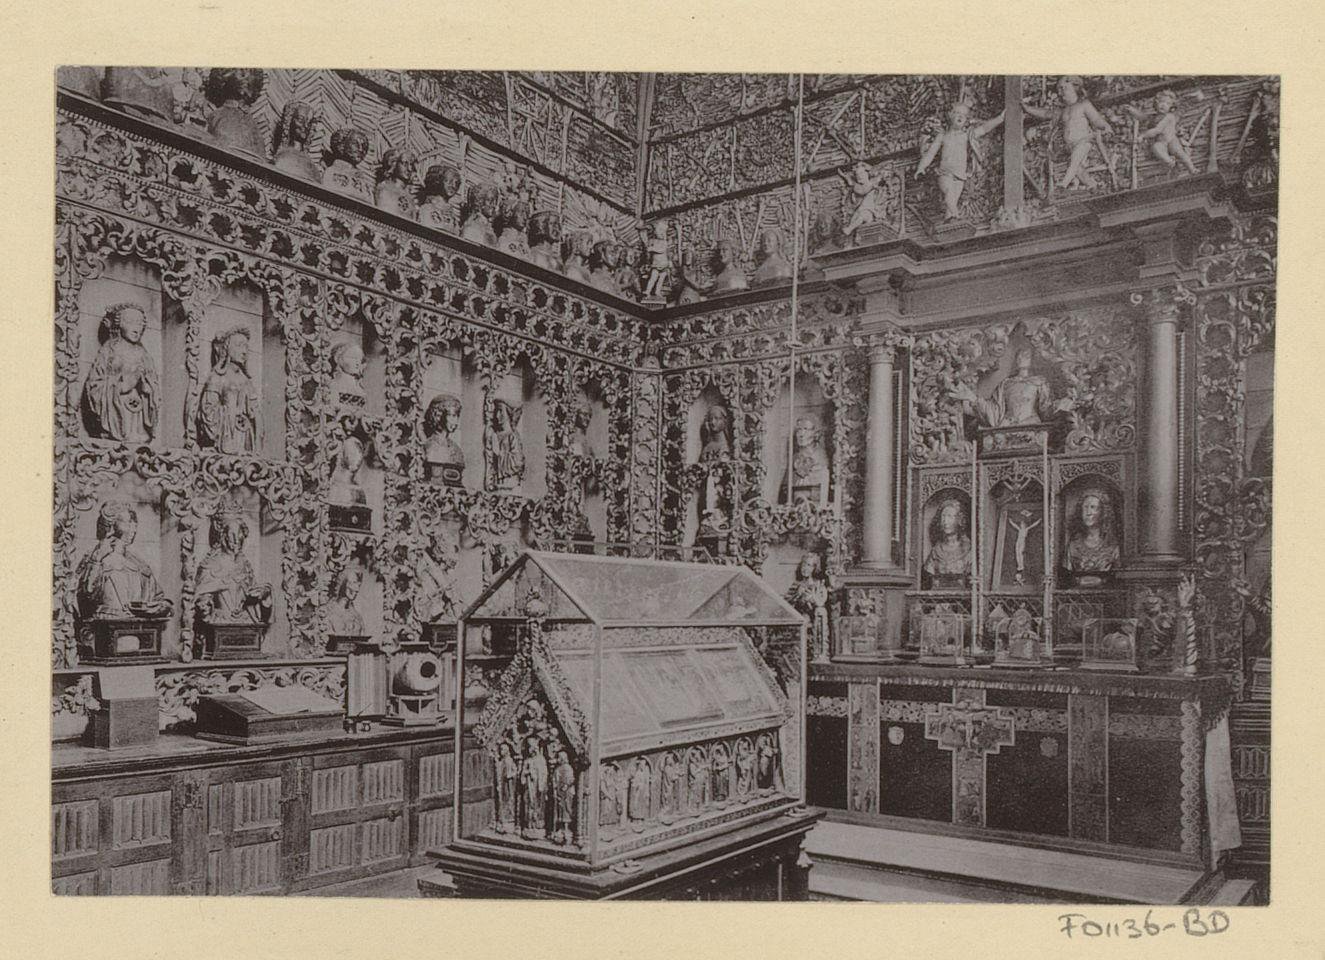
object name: photomechanical print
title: Interieur van de schatkamer van de Dom van Keulen met op de voorgrond een reliekschrijn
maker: Anonymous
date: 1880-1895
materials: paper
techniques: photograph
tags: relics (and reliquaries), historical persons (+ (full) bust portrait)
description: Onderdeel van Fotoalbum met opnames van bezienswaardigheden in België, Duitsland en Noorwegen.